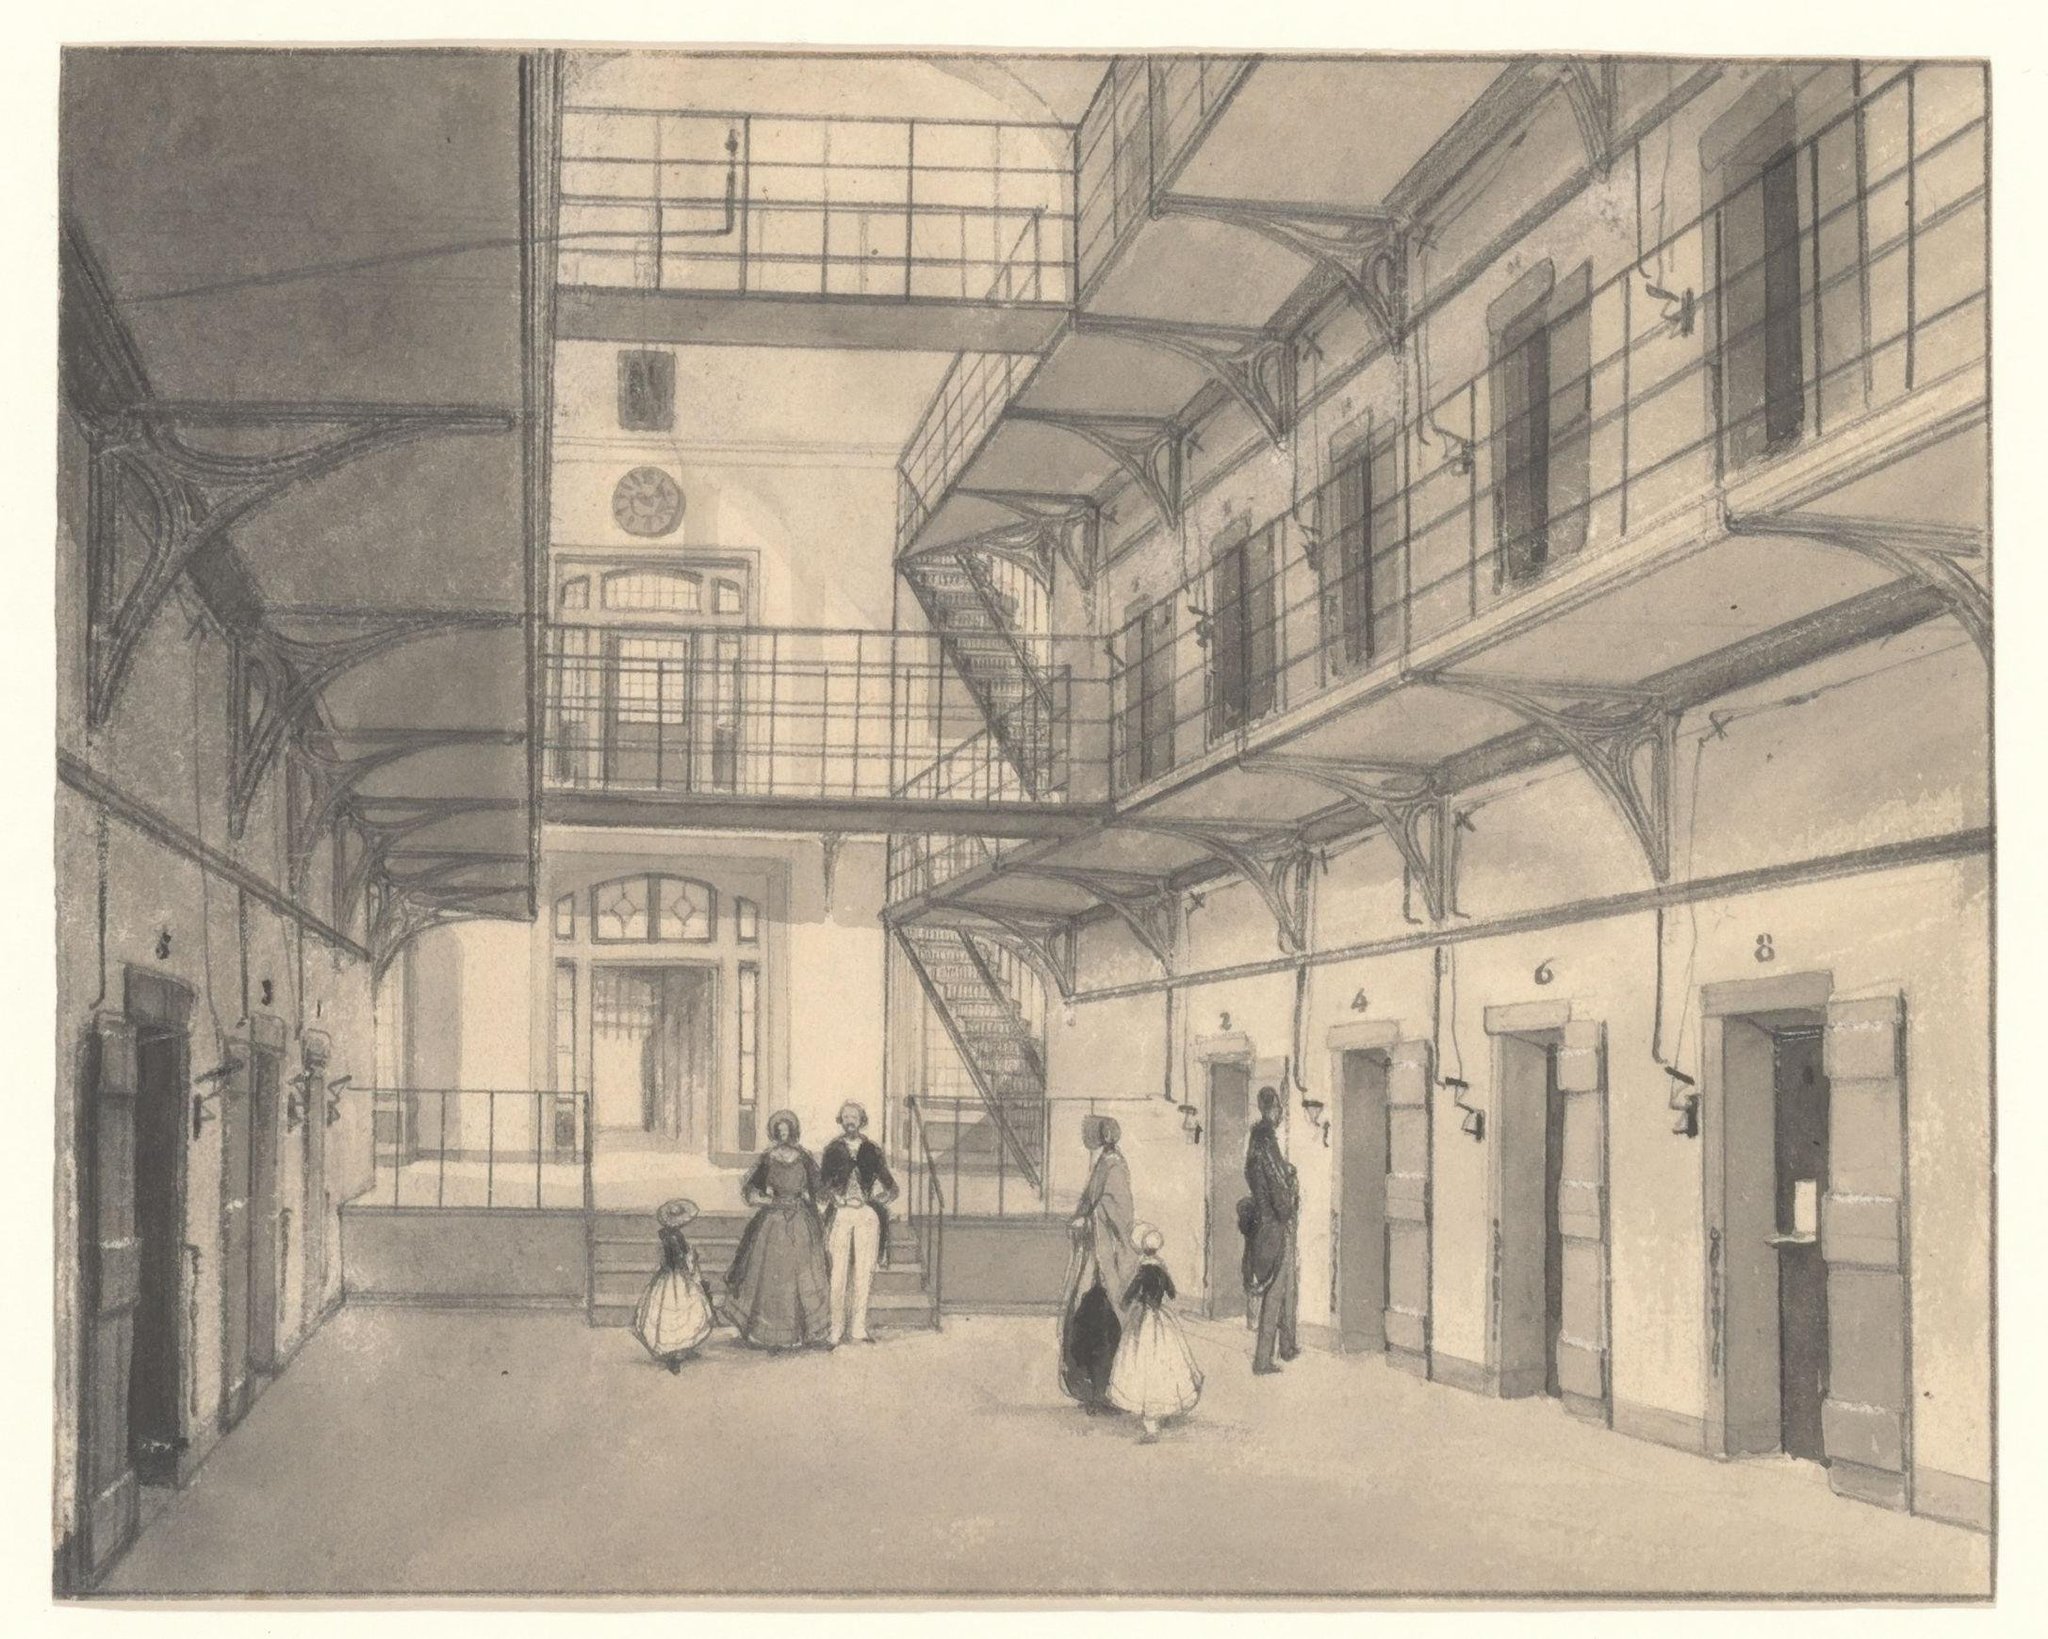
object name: drawing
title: Interieur van het Huis van Bewaring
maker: willem hekking jr.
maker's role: print maker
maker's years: 1825-1904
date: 1850-1904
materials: ink, paper, pencil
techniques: brush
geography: amsterdam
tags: prison, jail, city-view in general; 'veduta'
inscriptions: collector's mark: Lugt 800a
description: Tekening binnen de Atlas Van Eck ingedeeld op wijknummer 24.